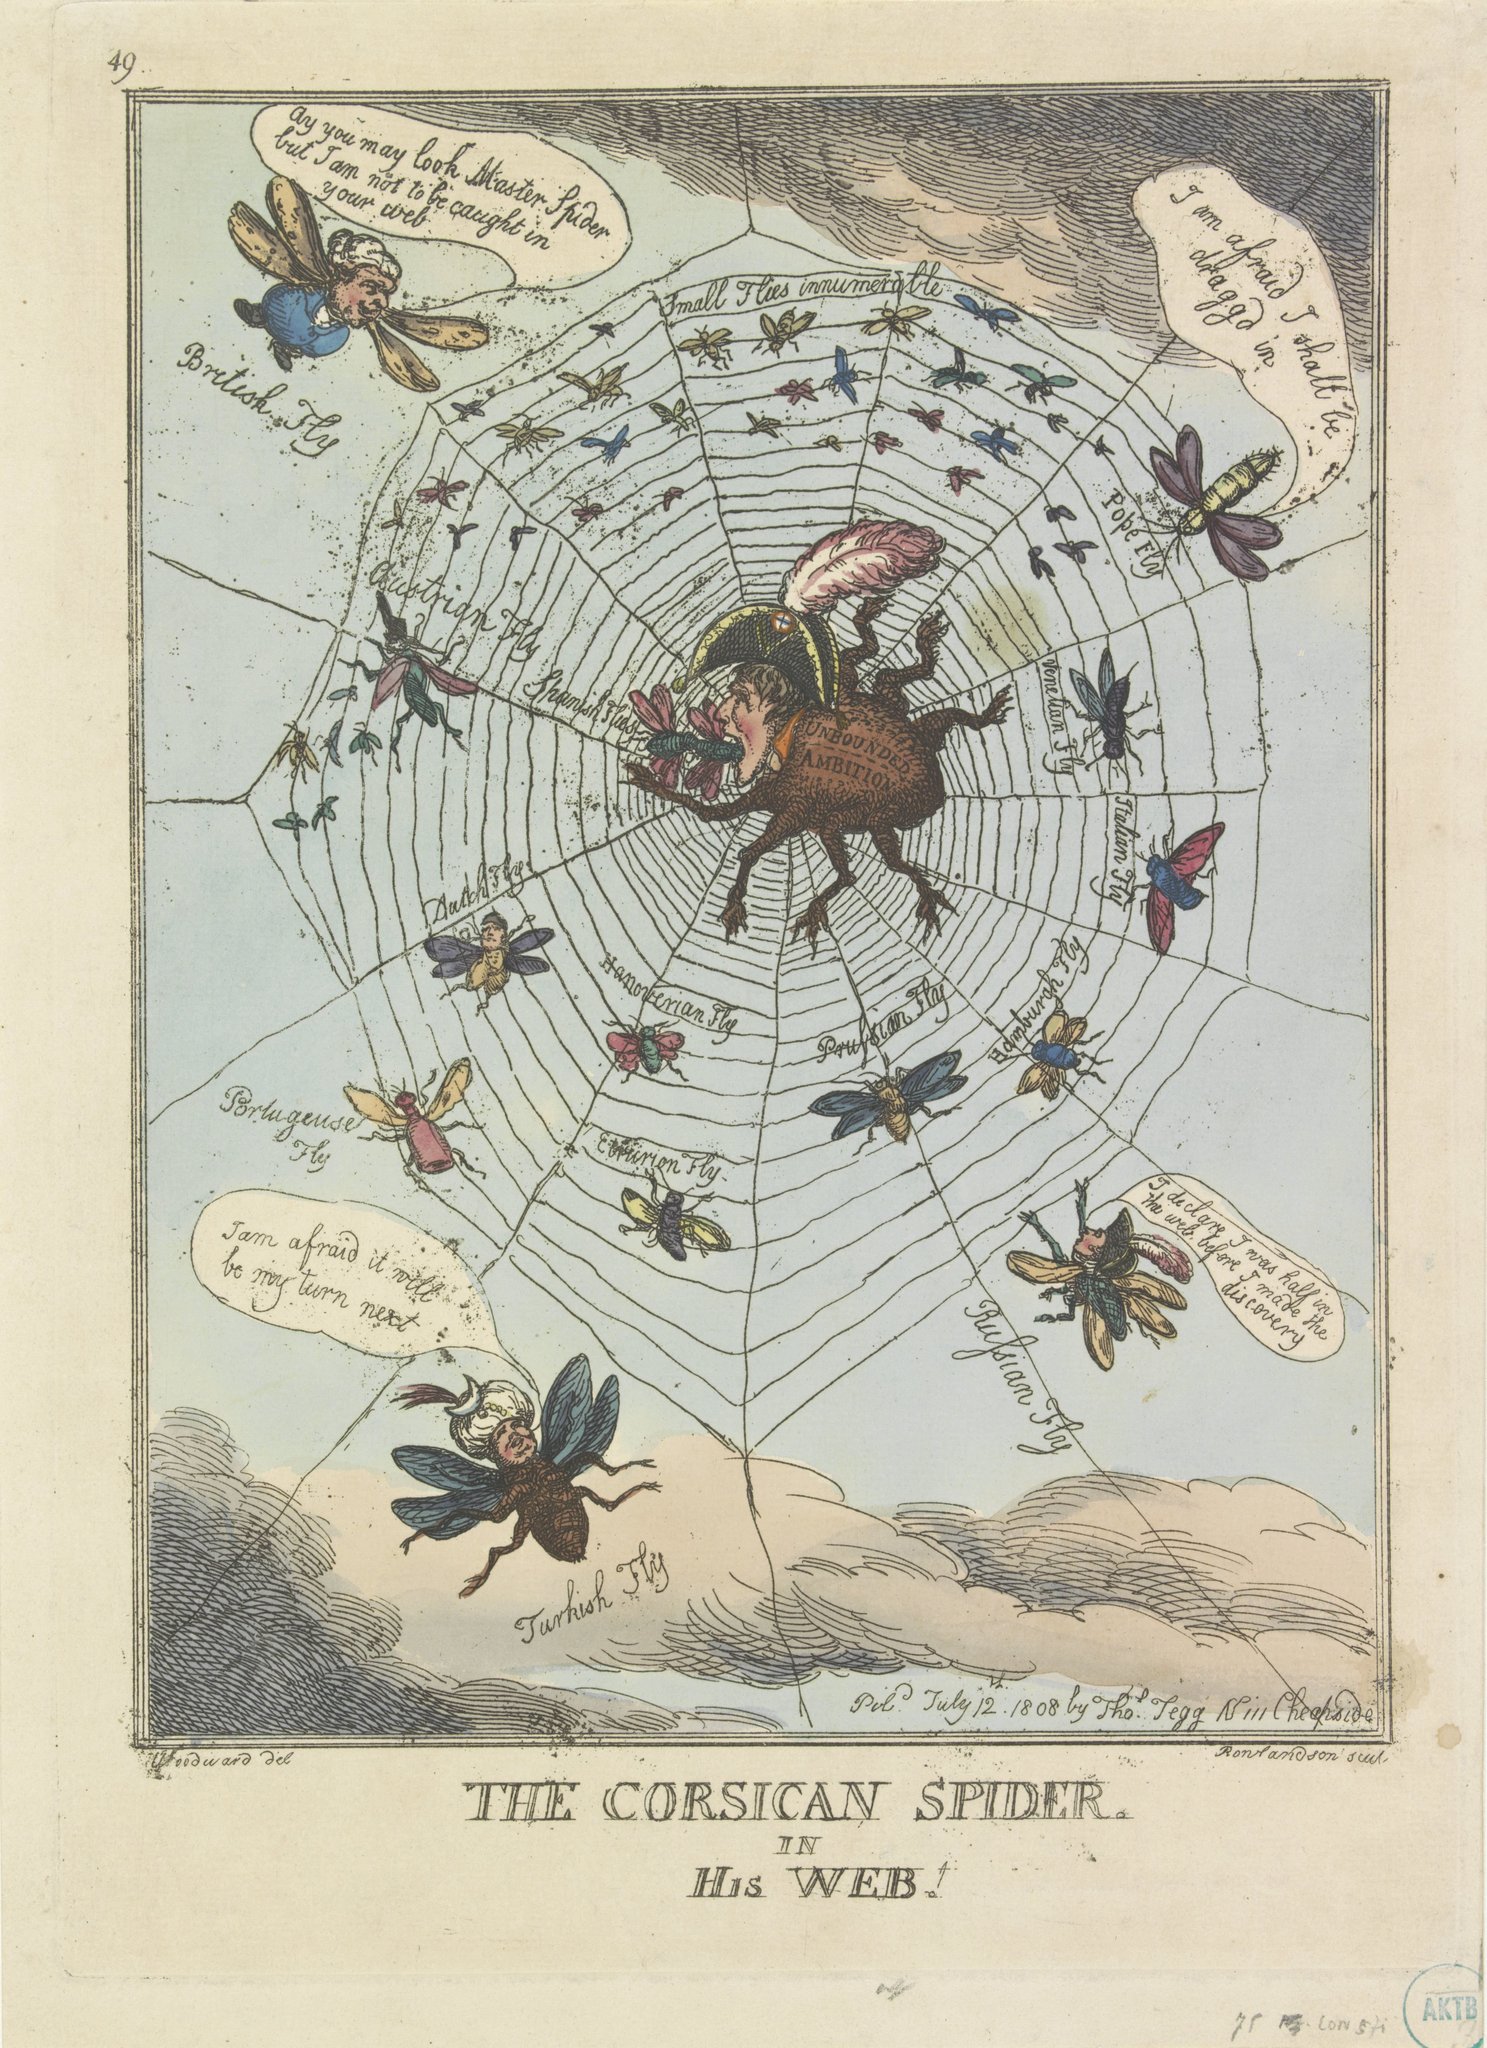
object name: print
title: The Corsican Spider, in His Web!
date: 1808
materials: paper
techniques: etching, hand coloring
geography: england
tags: napoleon i (emperor of the french), spiders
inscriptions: collector's mark: Lugt 2760, collector's mark: Lugt 2228, collector's mark: ‘AKTB’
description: Napoleon als een spin in het midden van zijn web verslindt buitenlandse naties voorgesteld als vliegen. Napoleon is bezig Spanje op te eten, vele andere landen (waaronder Nederland) zitten al vast in het web, andere landen (Groot-Brittannië, Turkije, Rusland en de paus) vliegen nog vrij rond en leveren commentaar. Genummerd linksboven: 49.